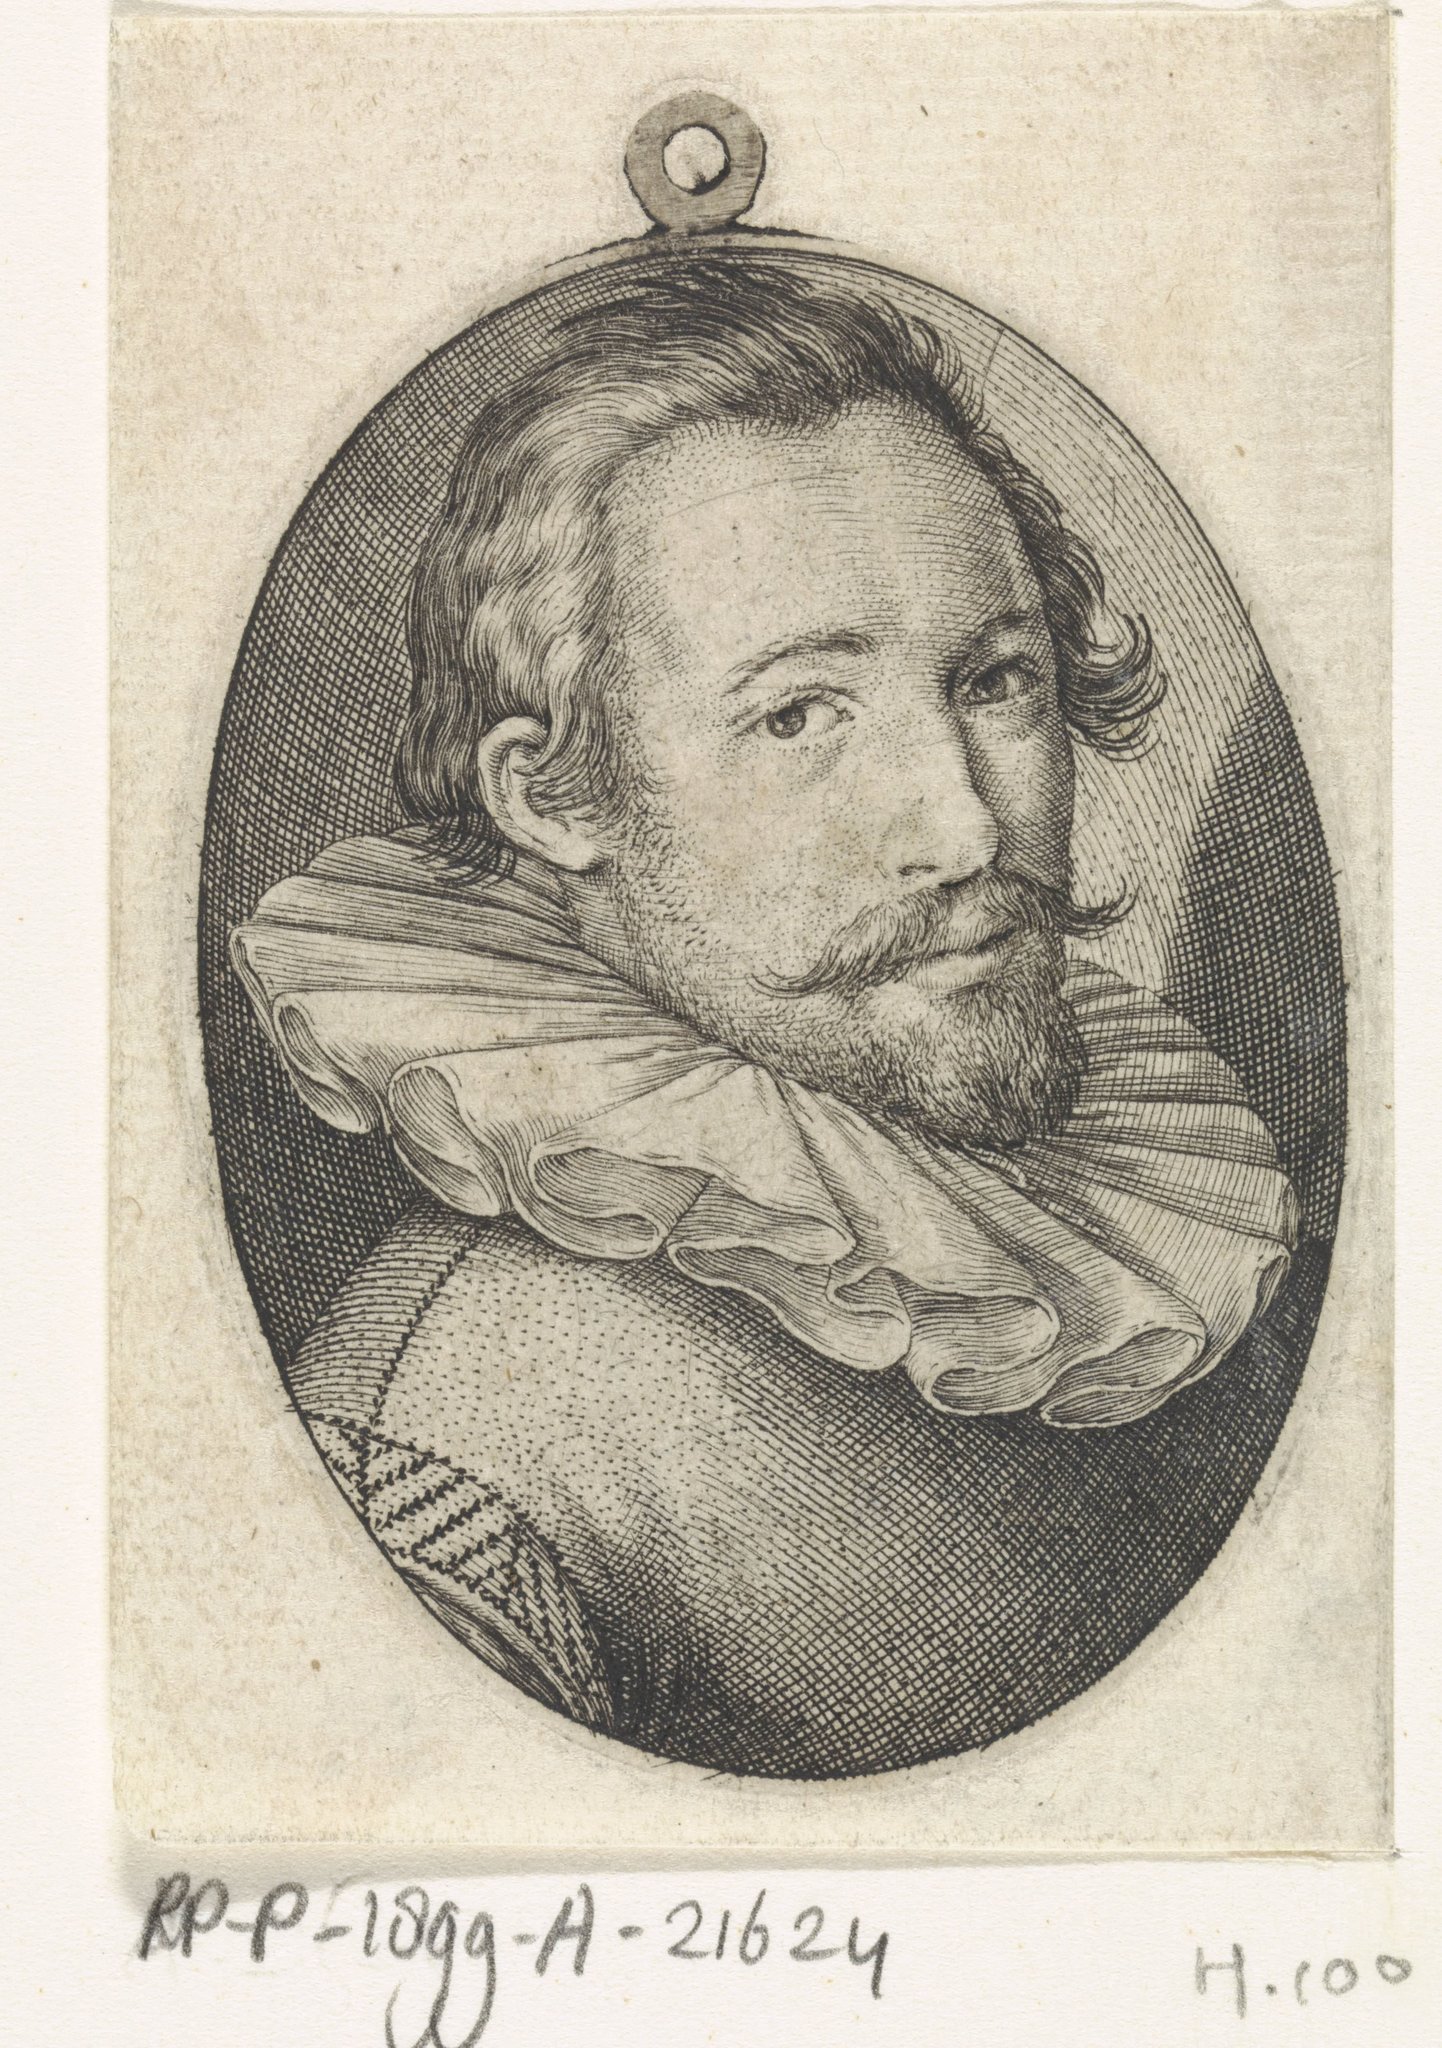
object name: print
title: Portret van een man met een geplooide kraag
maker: Anonymous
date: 1600-1699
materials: paper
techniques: engraving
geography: netherlands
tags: adult man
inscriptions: collector's mark: Lugt 2228